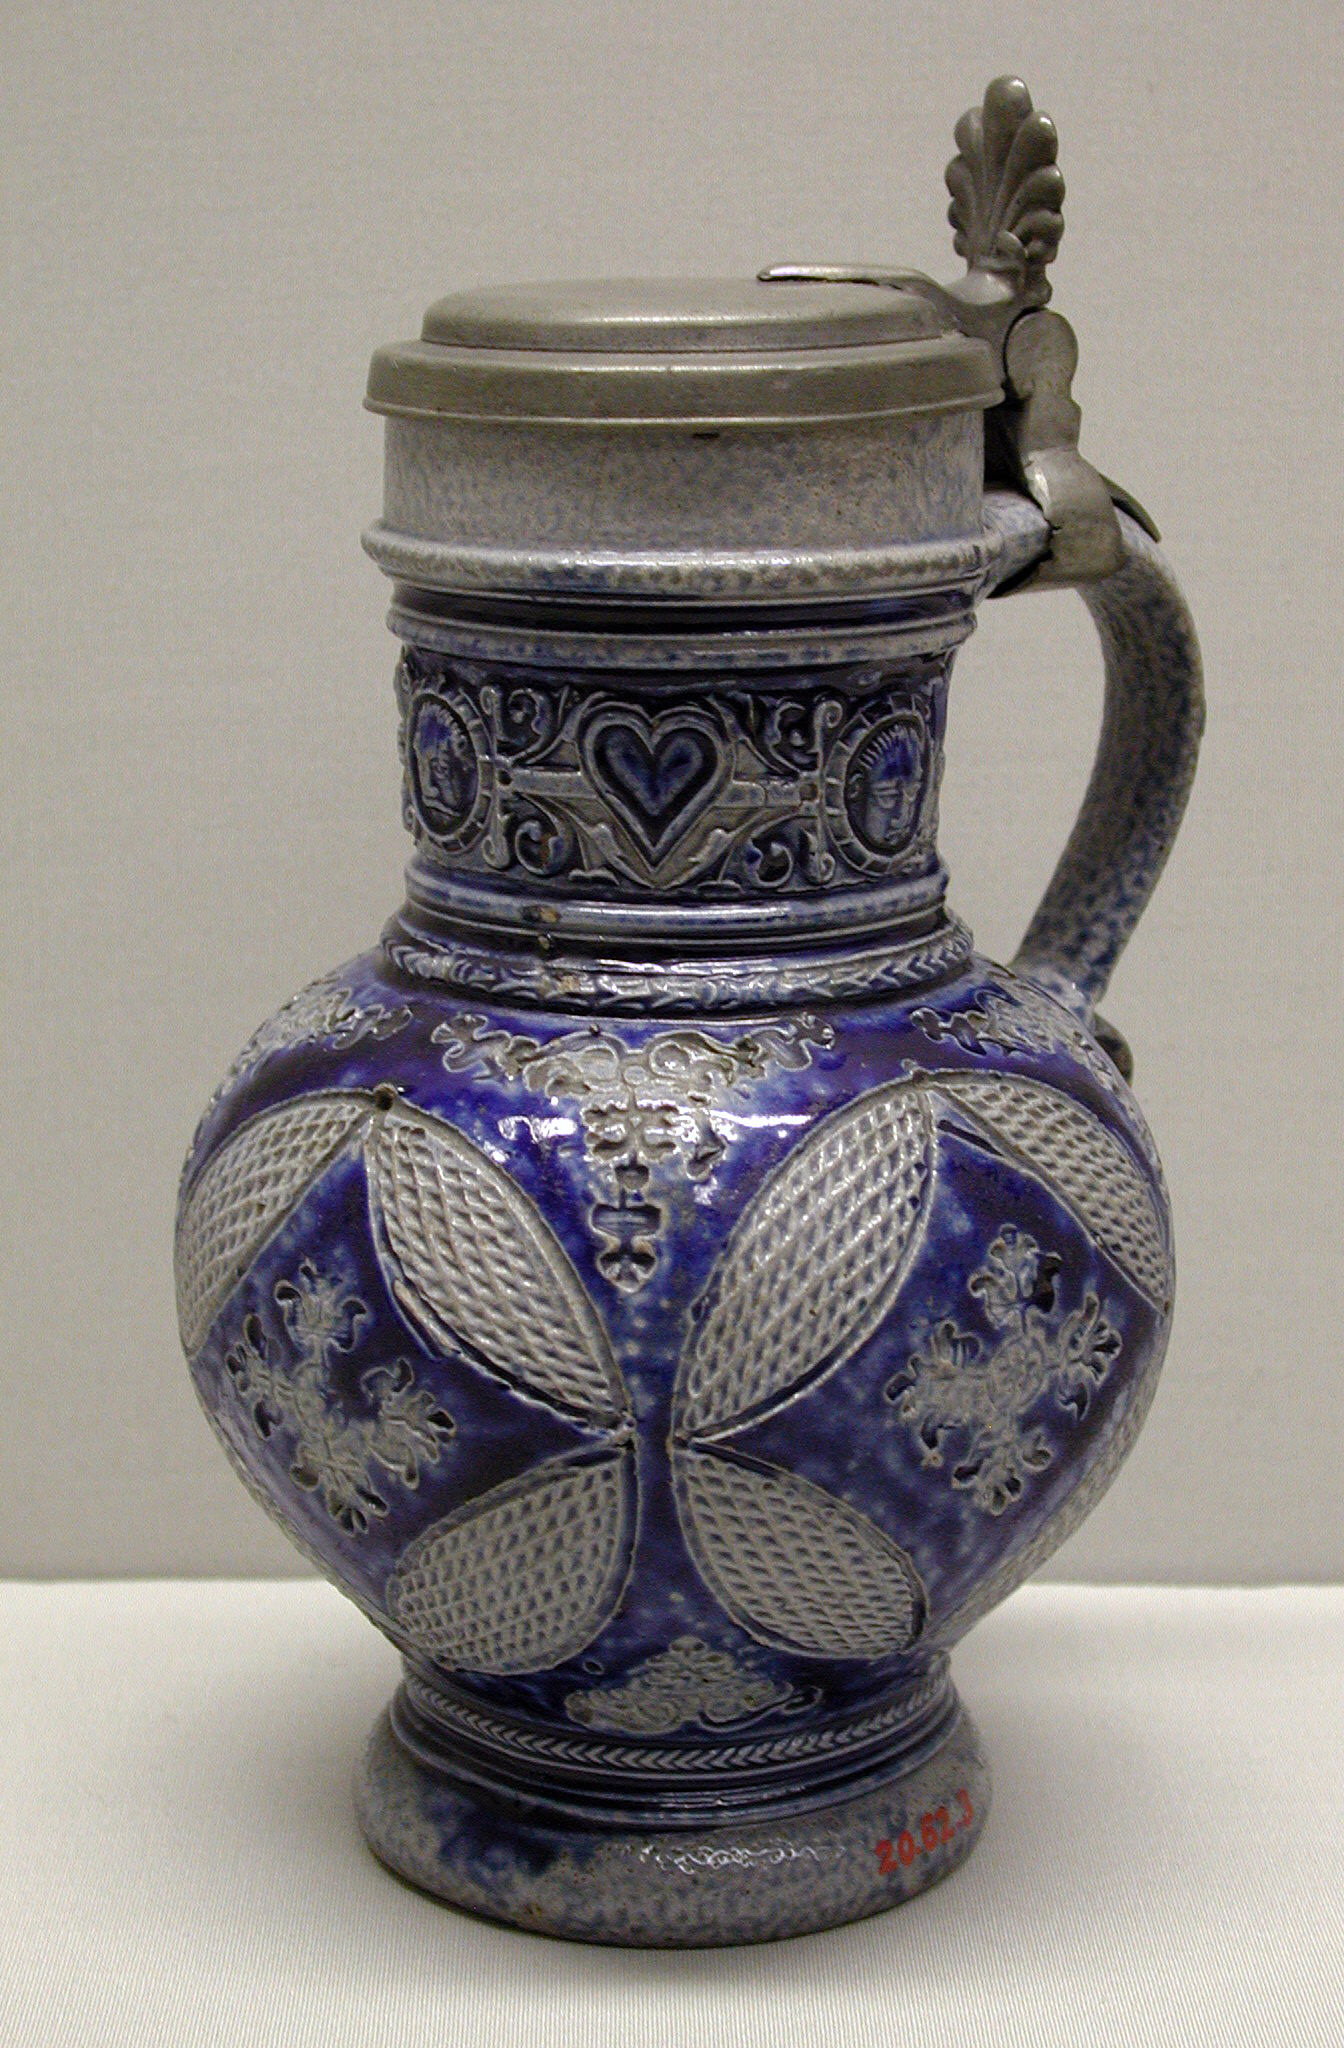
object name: flagon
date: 1767-1800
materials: pewter, stoneware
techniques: salt glaze